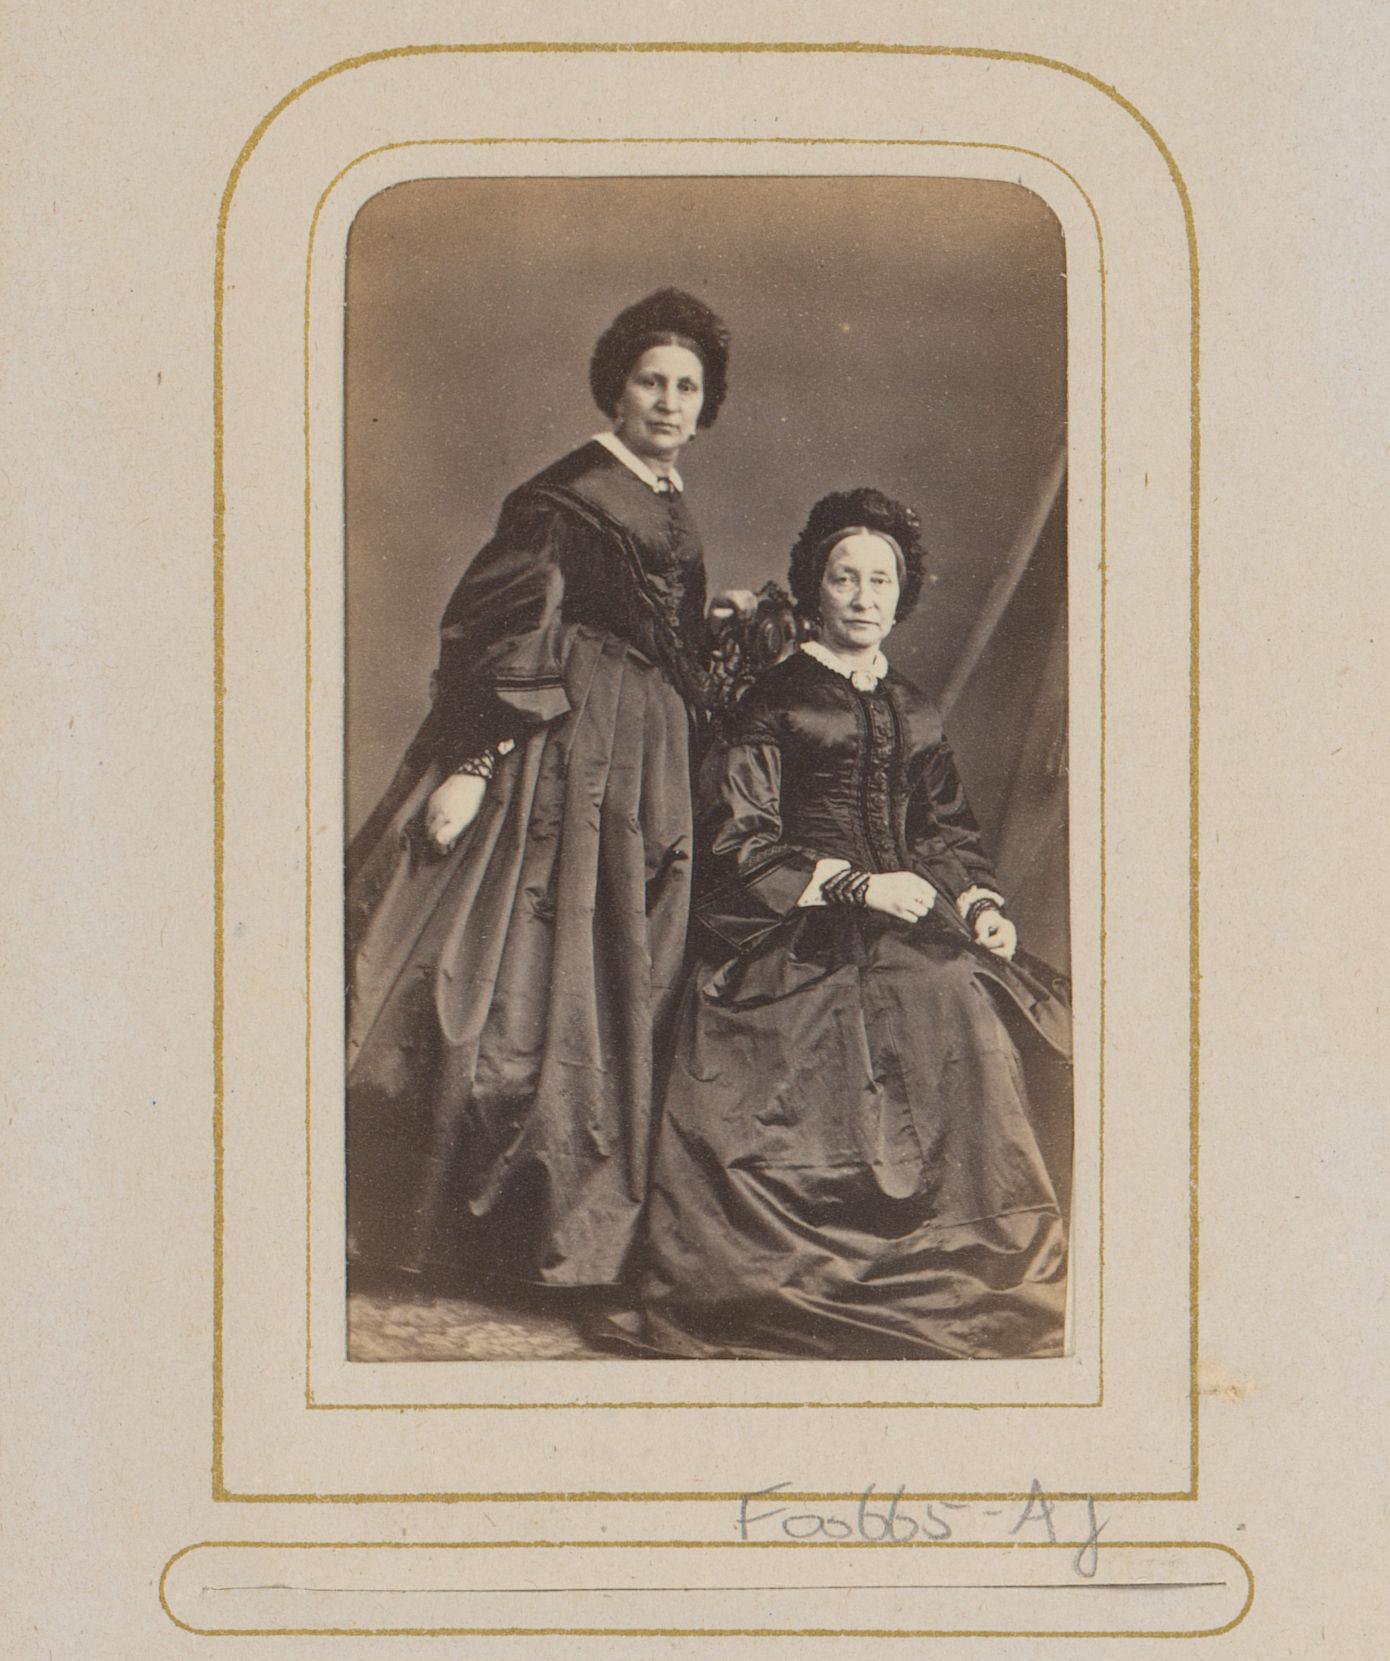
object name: carte de visite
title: Portret van twee oude vrouwen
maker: Anonymous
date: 1855-1880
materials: cardboard, photographic support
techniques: albumen print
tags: historical persons - bb - woman, old woman